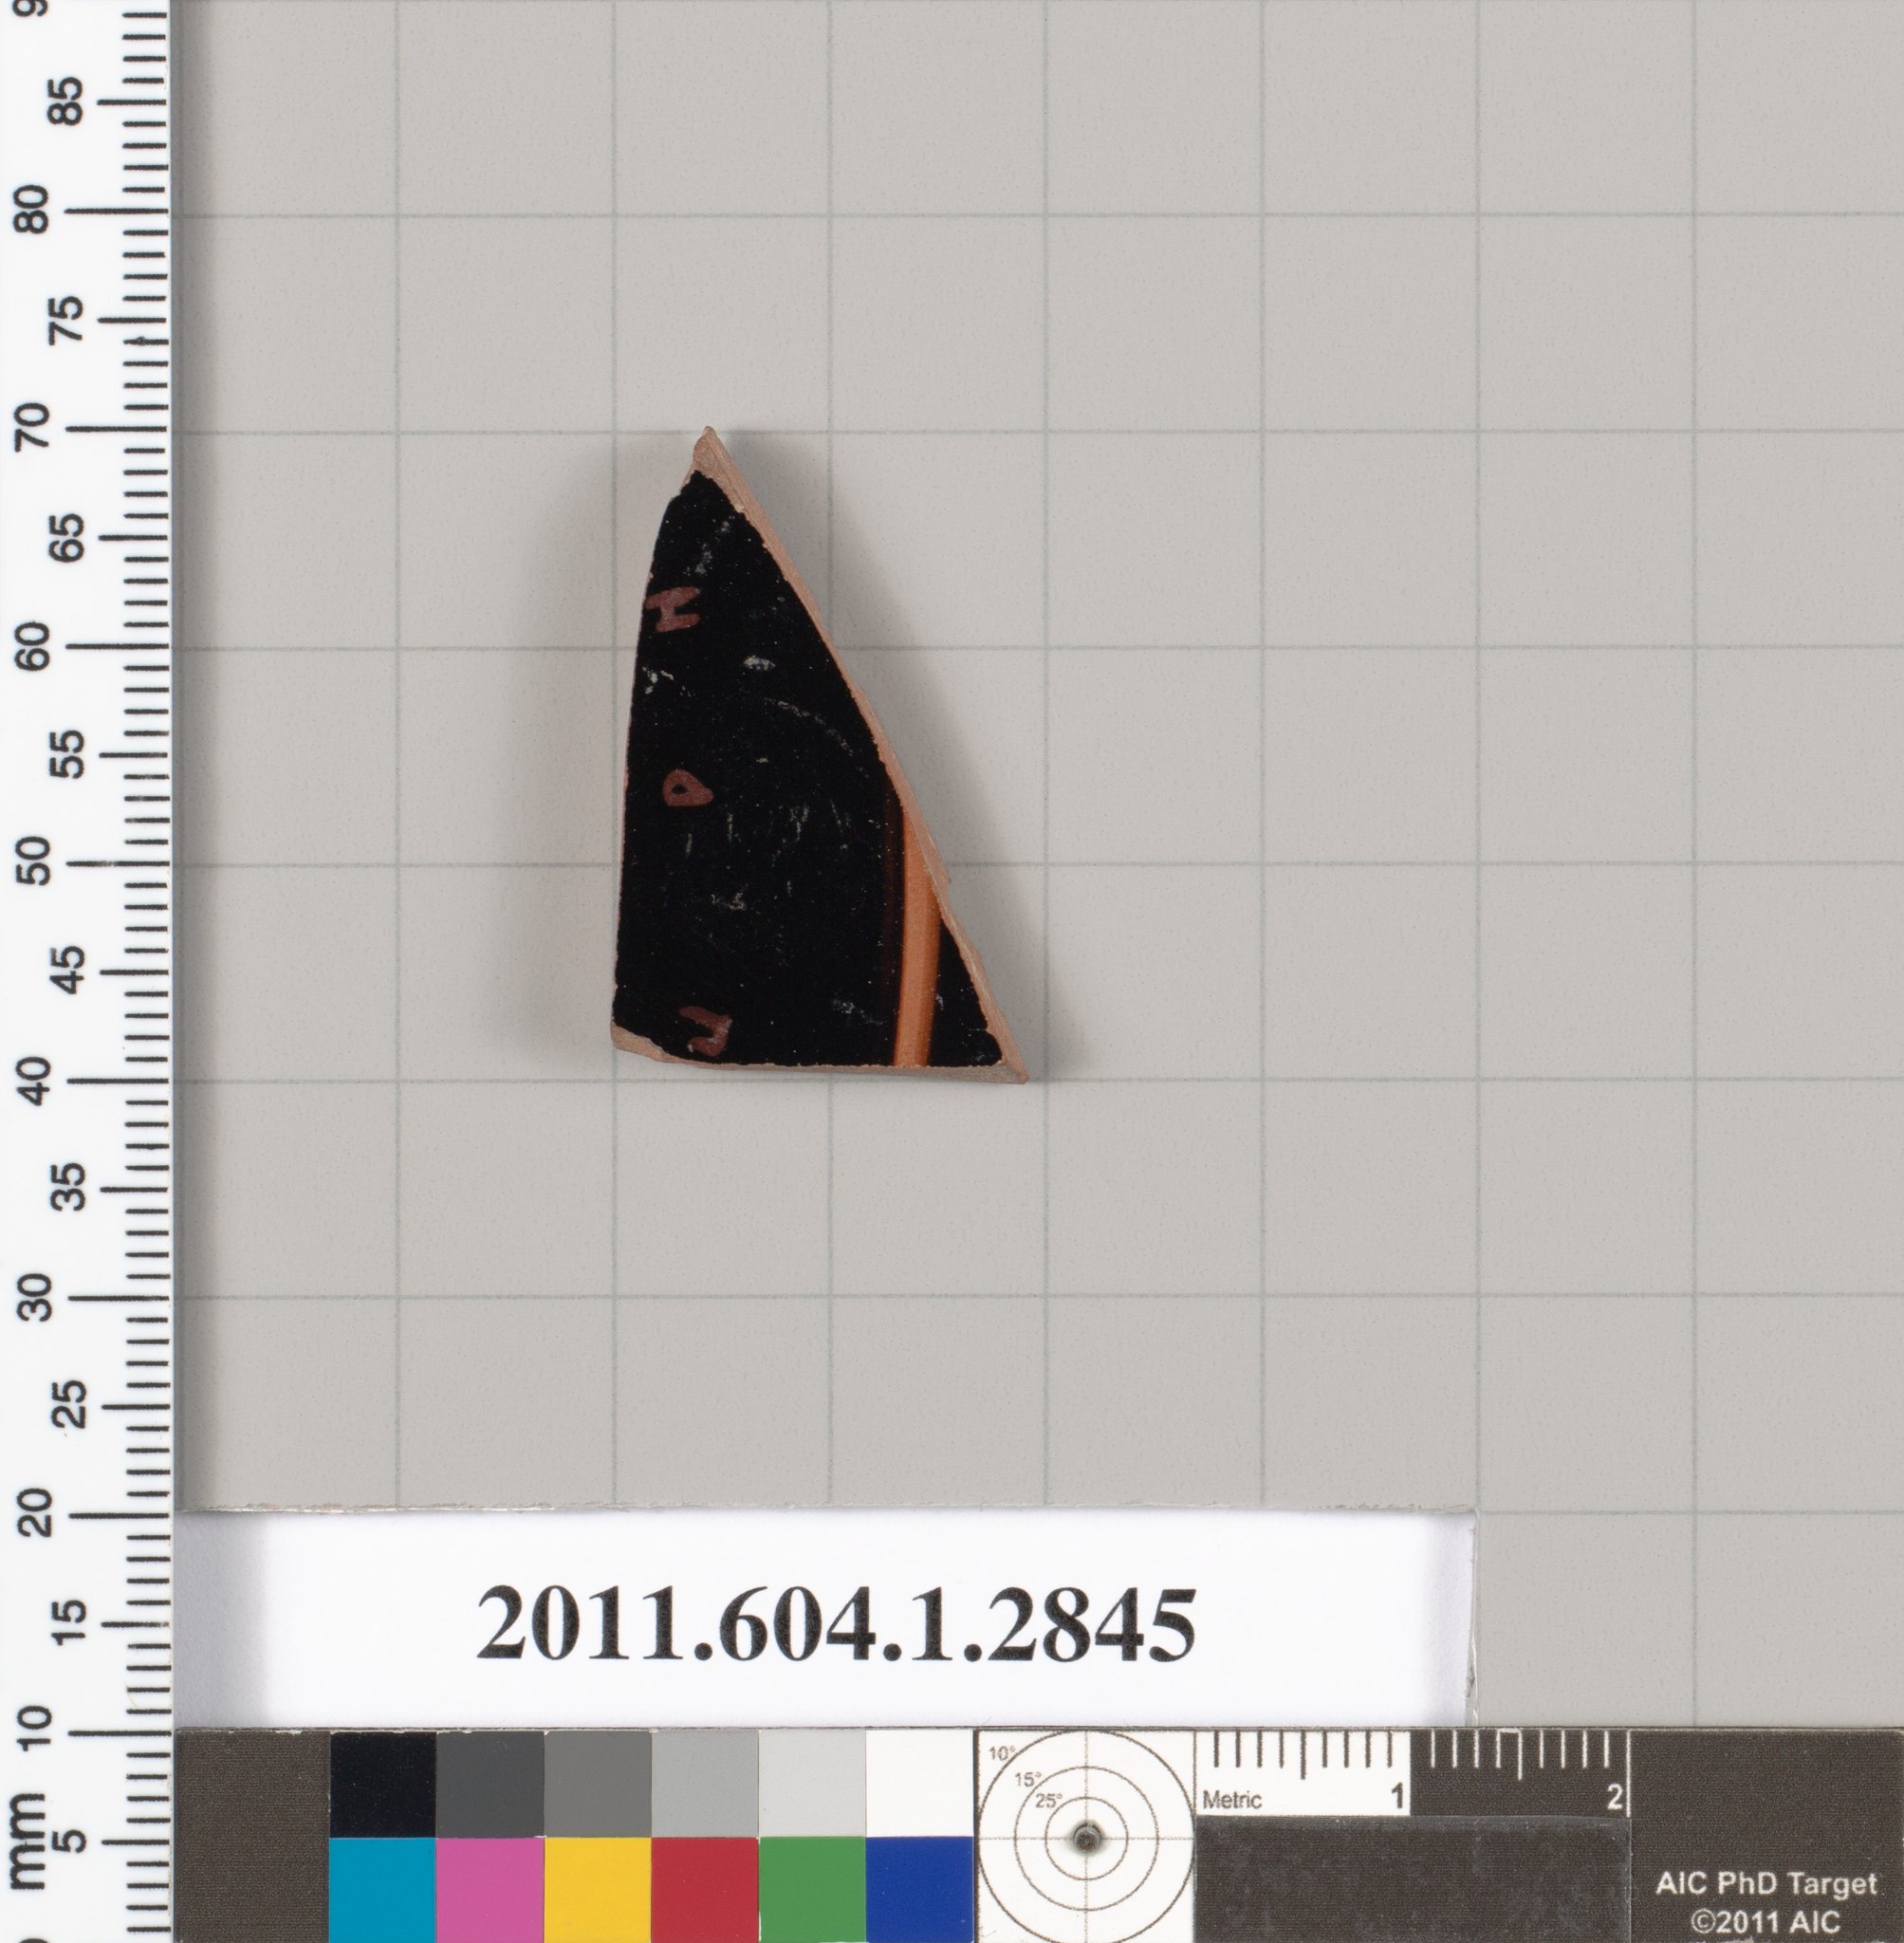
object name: kylix fragment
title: Terracotta fragment of a kylix (drinking cup)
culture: greek, attic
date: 520-480 BCE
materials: terracotta